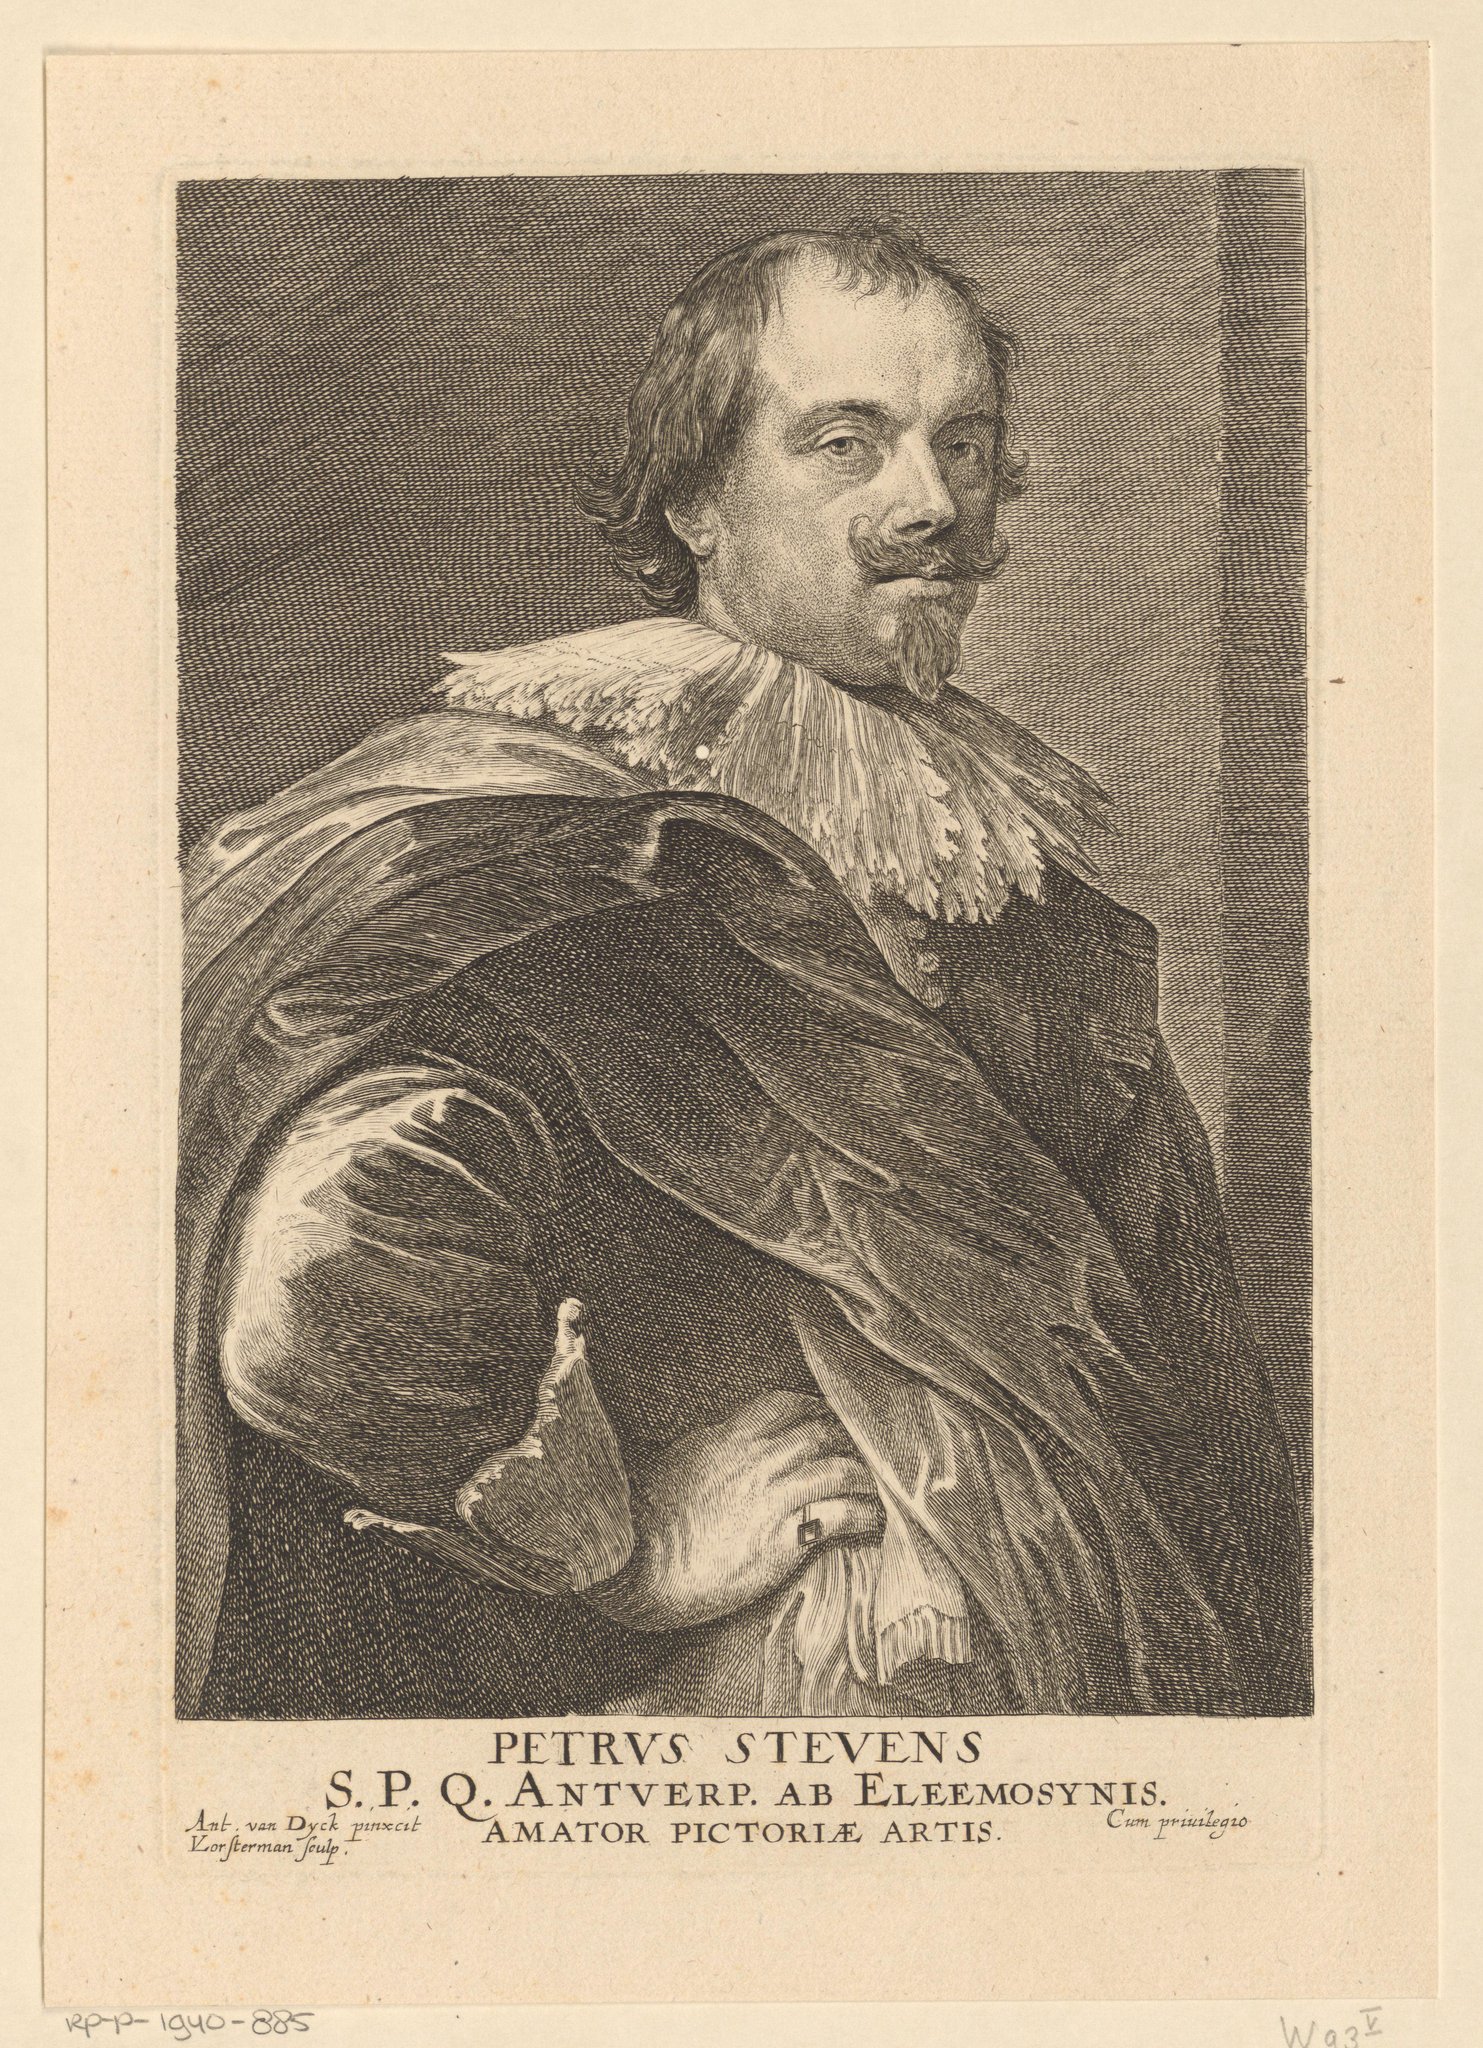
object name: print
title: Portret van Peeter Stevens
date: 1630-1646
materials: paper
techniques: engraving, etching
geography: antwerp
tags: antwerp, historical persons, art collector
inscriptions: collector's mark: Lugt 2228, collector's mark: Lugt 2760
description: Prent waarschijnlijk uit: Icones principum, virorum doctorum, pictorum, chalcographorum, statuariorum nec non amatorum pictoriae artis numero centum ab Ant. van Dyck ad vivum expressae ejusque sumptibus aeri incisae. Antwerpen: Gillis Hendricx, [1645-1646].